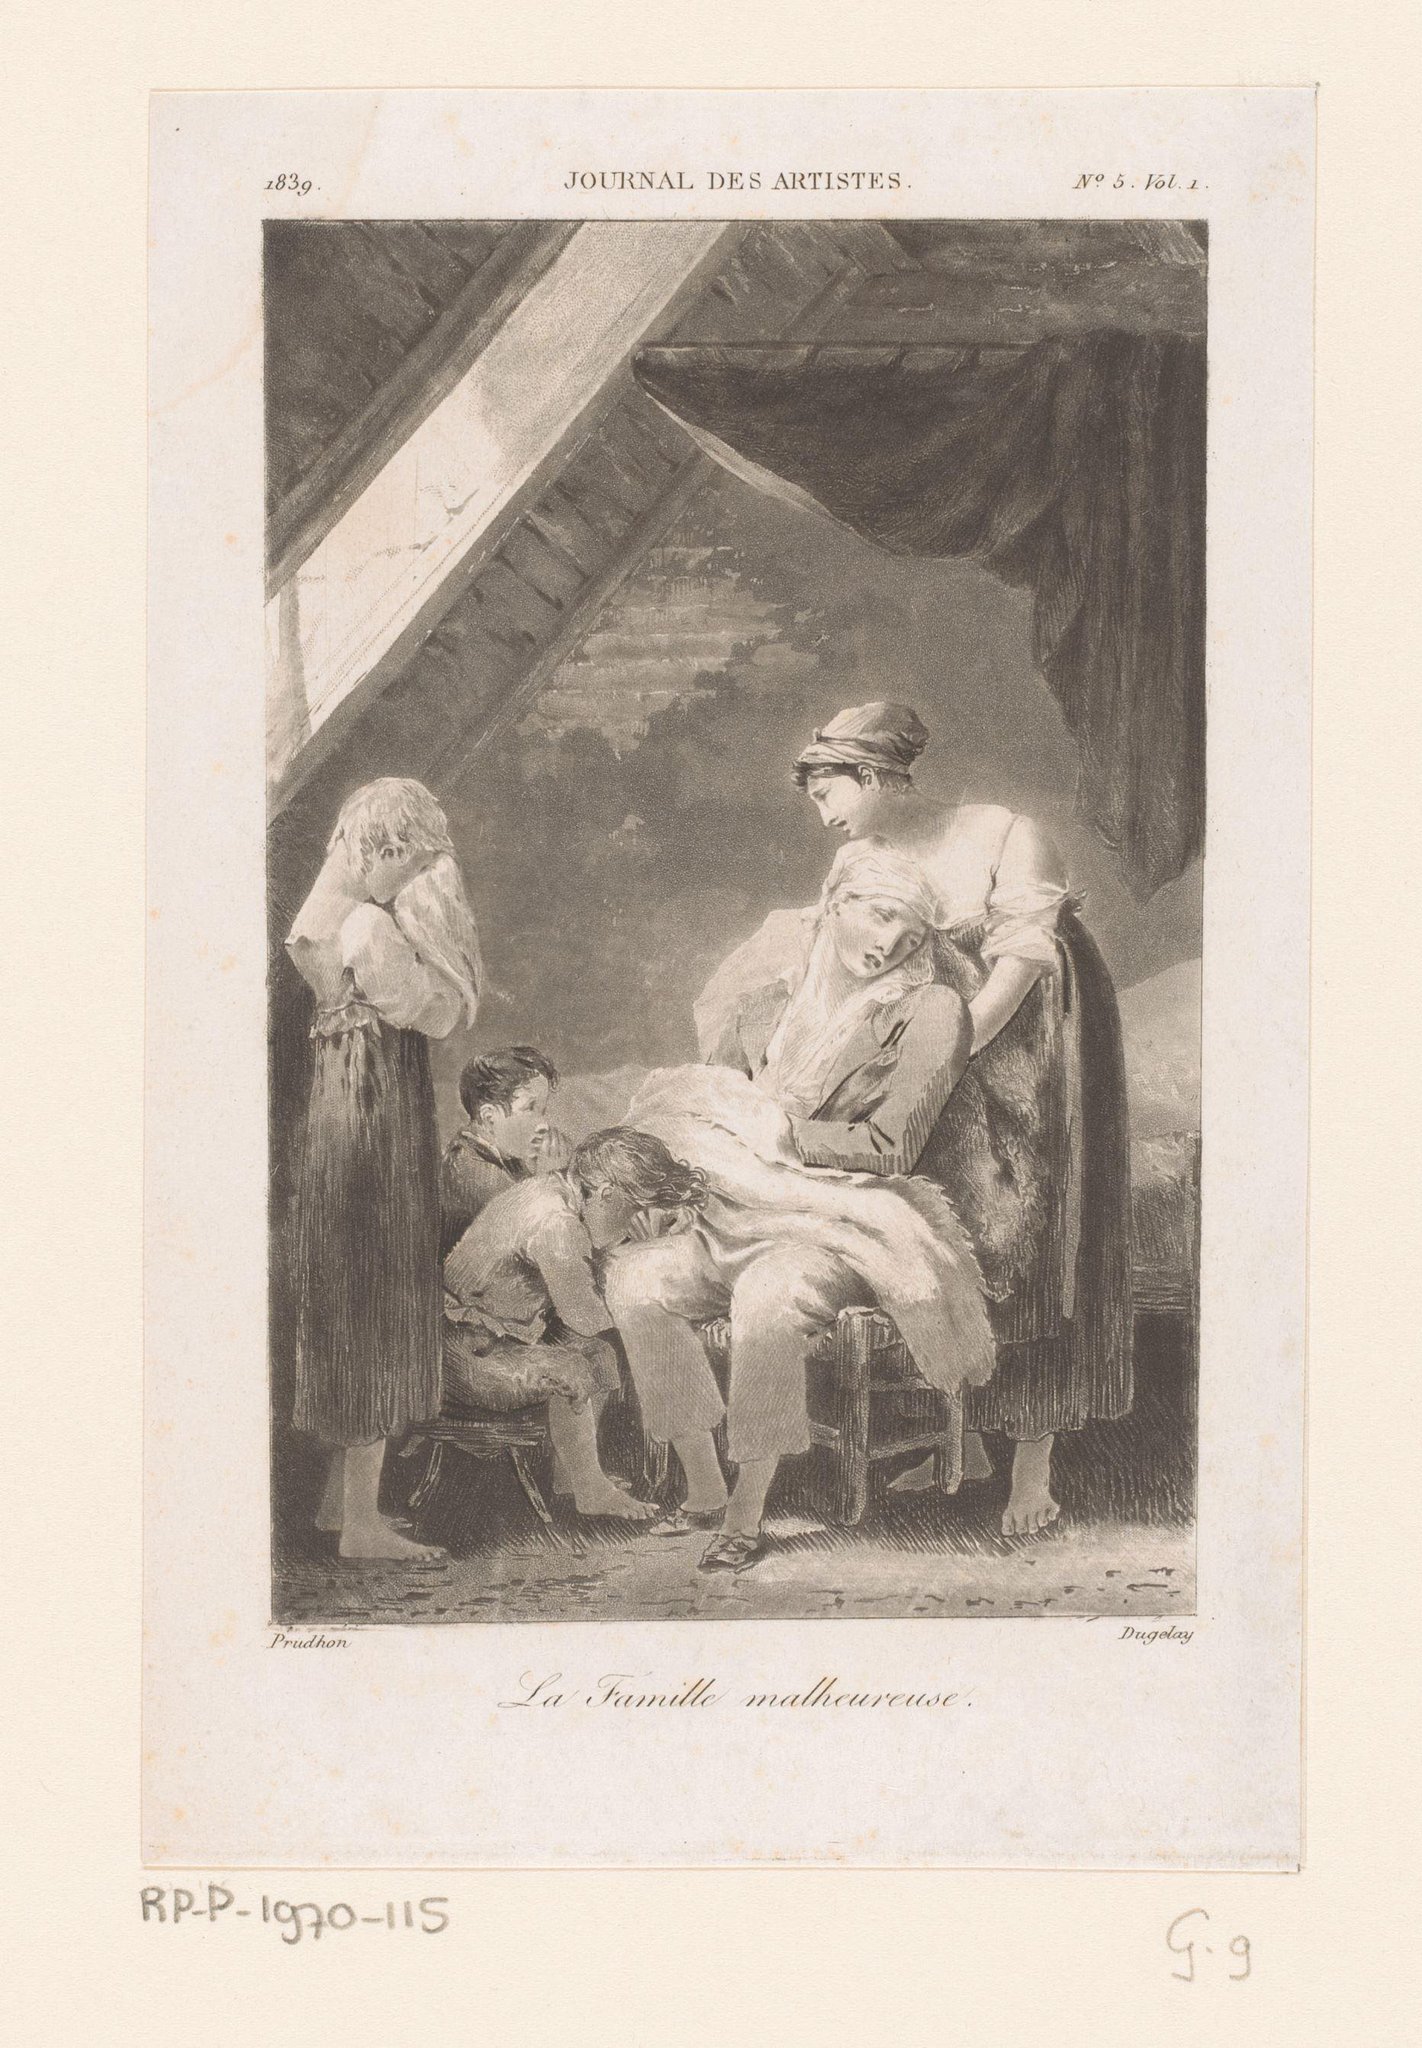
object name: print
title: La famille malheureuse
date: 1839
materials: paper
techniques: aquatint, etching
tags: family, relationship, descent, patient, sick person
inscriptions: collector's mark: Lugt 2760, collector's mark: Lugt 2228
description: Prent uit: Journal des artistes, 1839, no. 5, vol. 1.